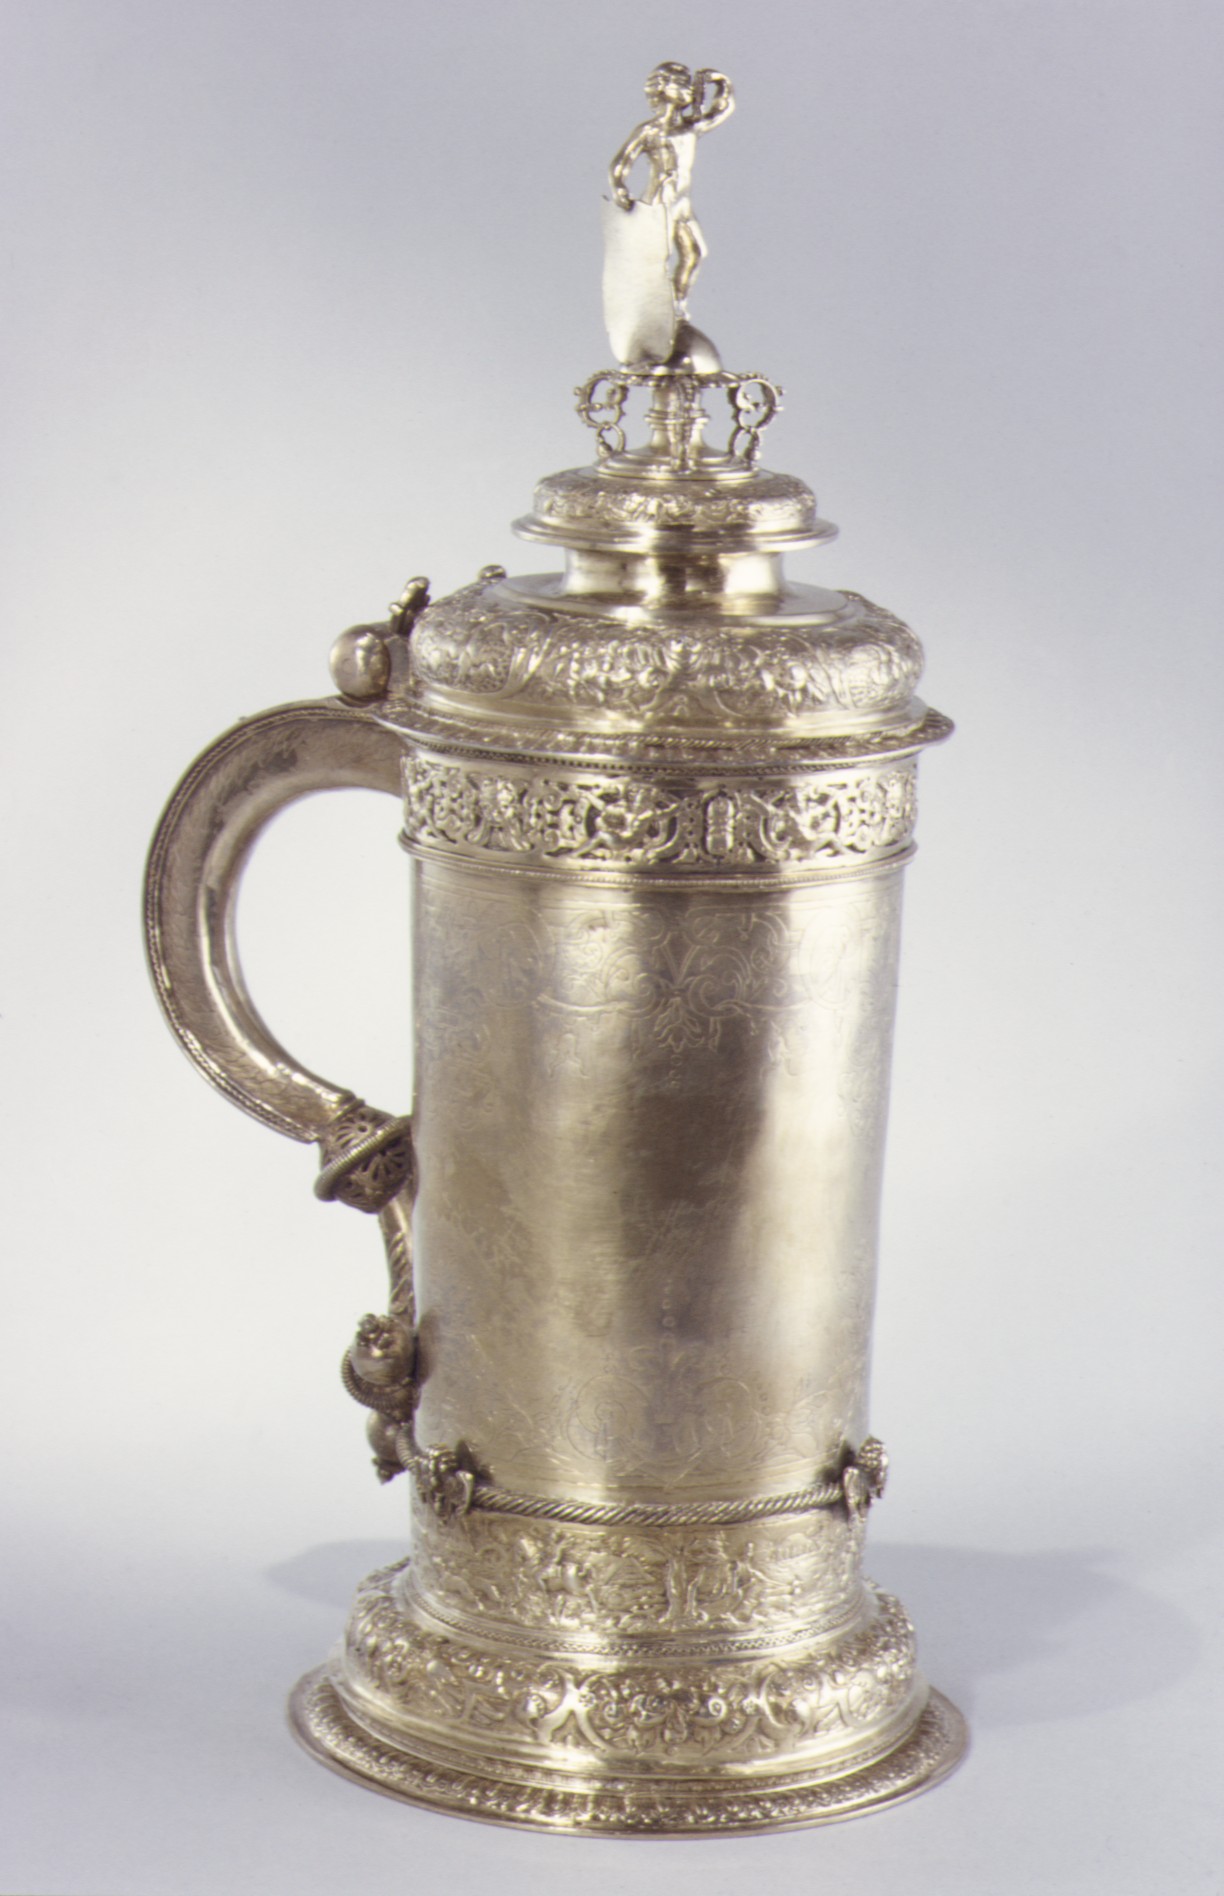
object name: flagon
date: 1567-1600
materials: silver gilt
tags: male nudes